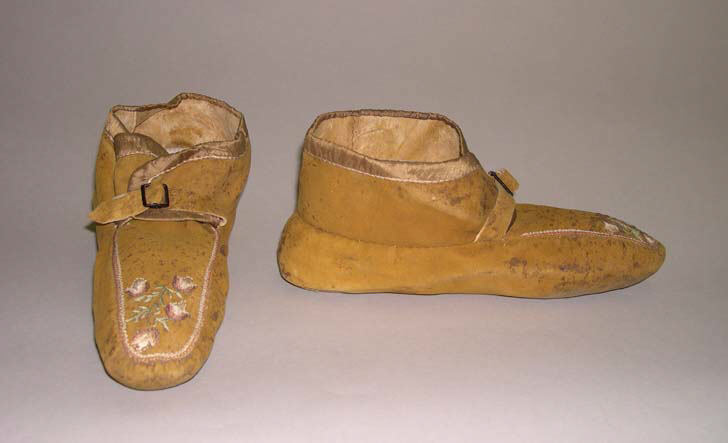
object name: moccasin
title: Moccasins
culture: american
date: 1835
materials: silk